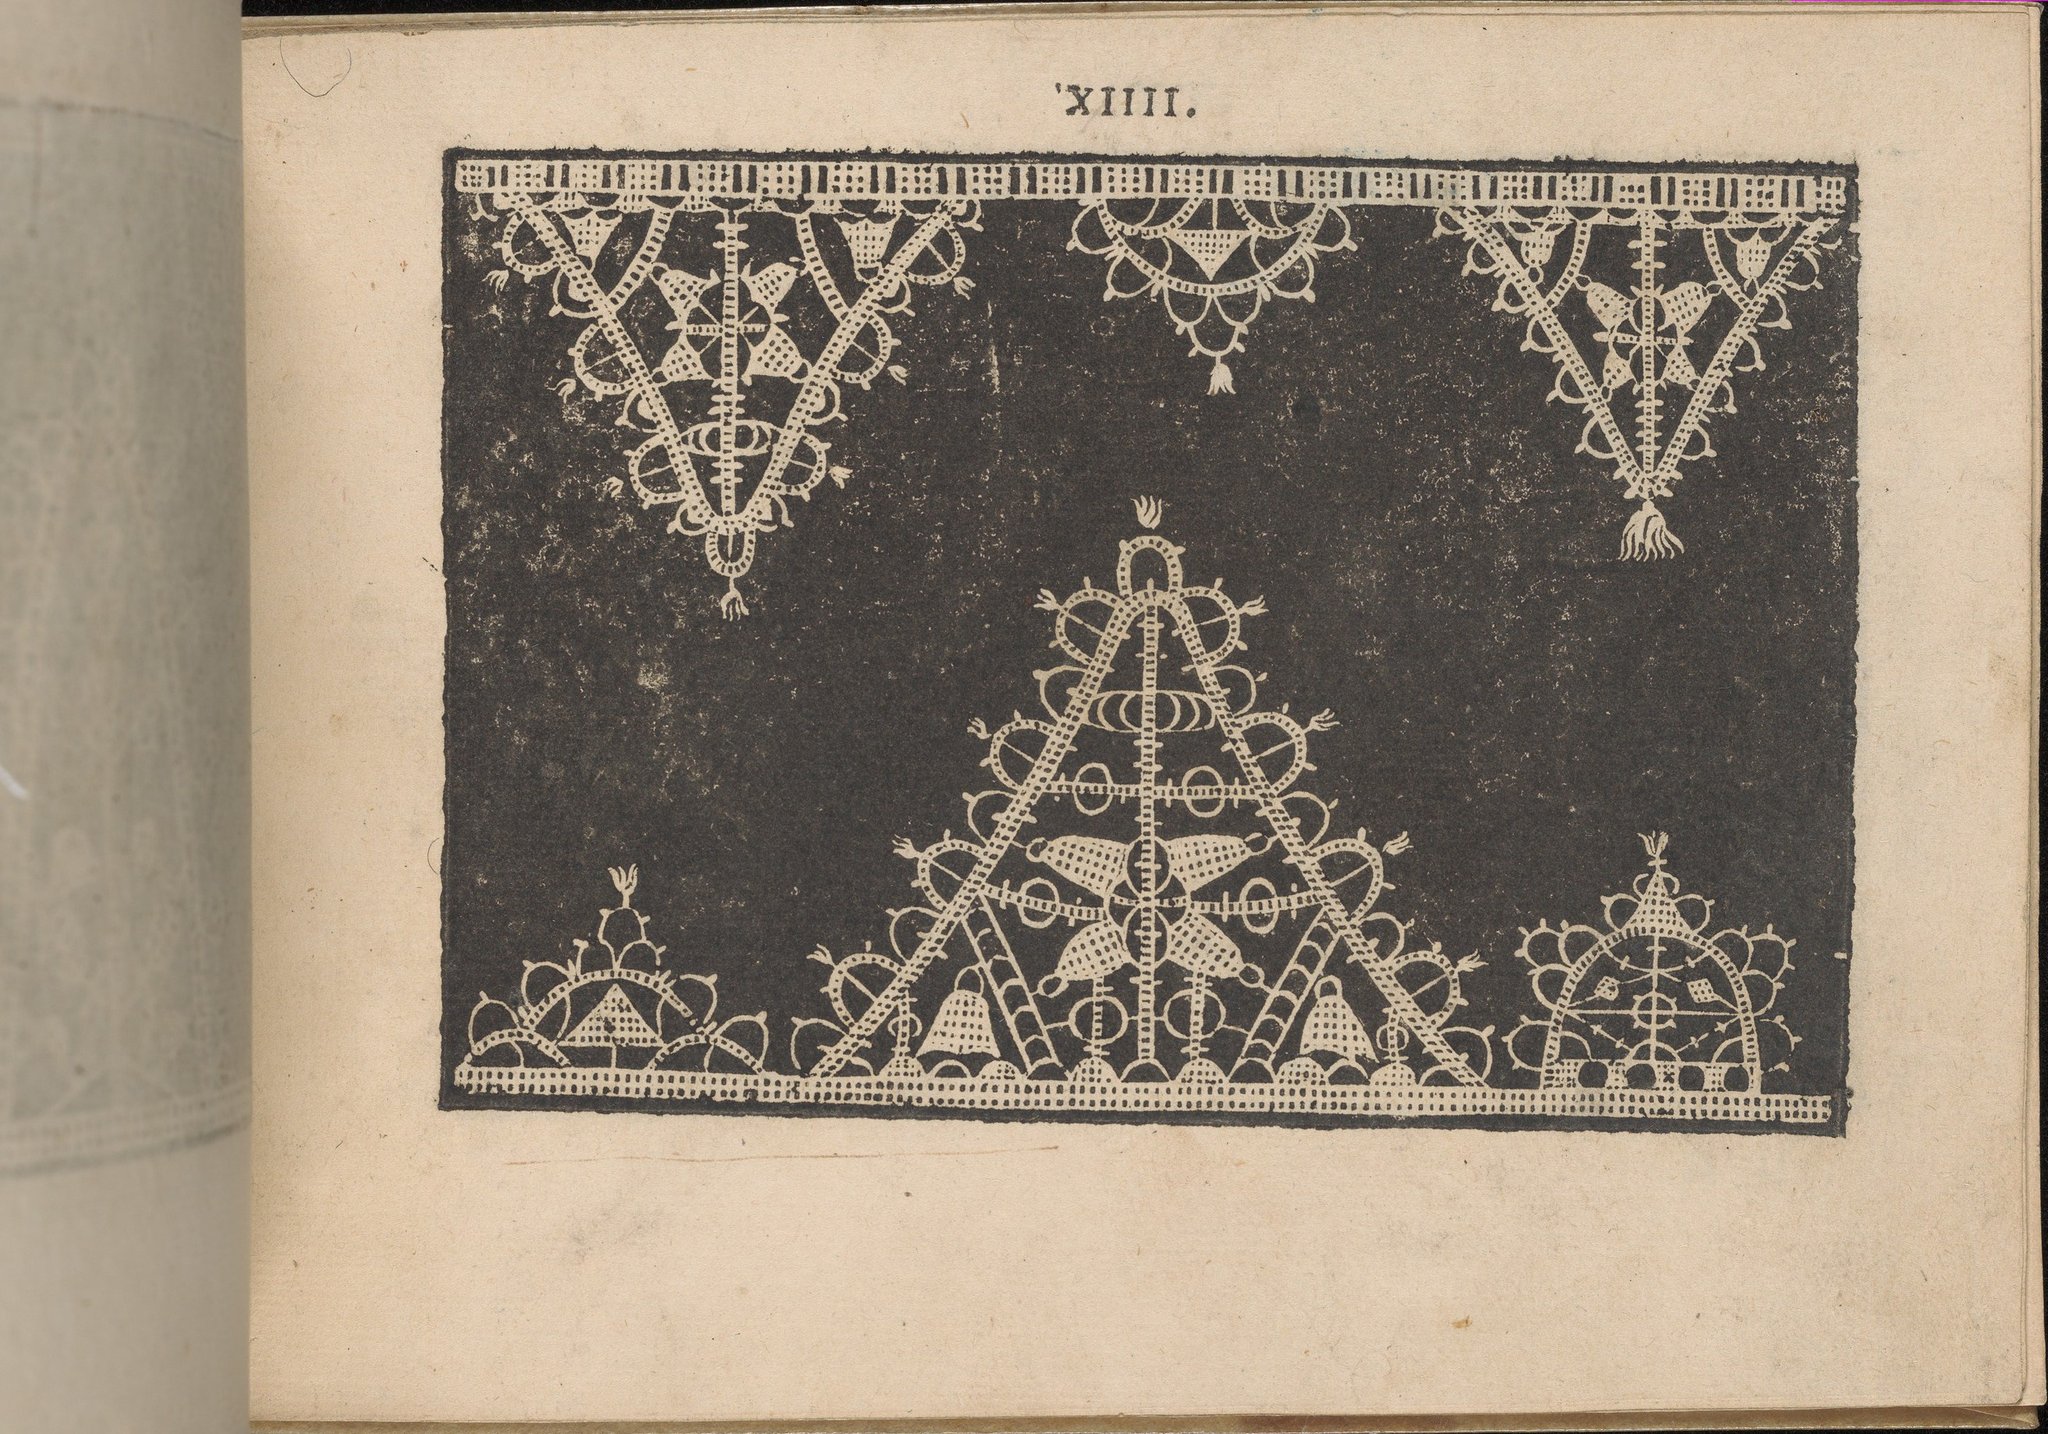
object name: book print ornament architecture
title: Prima Parte de' Fiori, e Disegni di varie sorti di Ricami Moderni, page 14 (recto)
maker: giovanni battista ciotti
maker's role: author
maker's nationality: italian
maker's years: 1555-1659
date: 1591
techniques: woodcut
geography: italy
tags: ornament